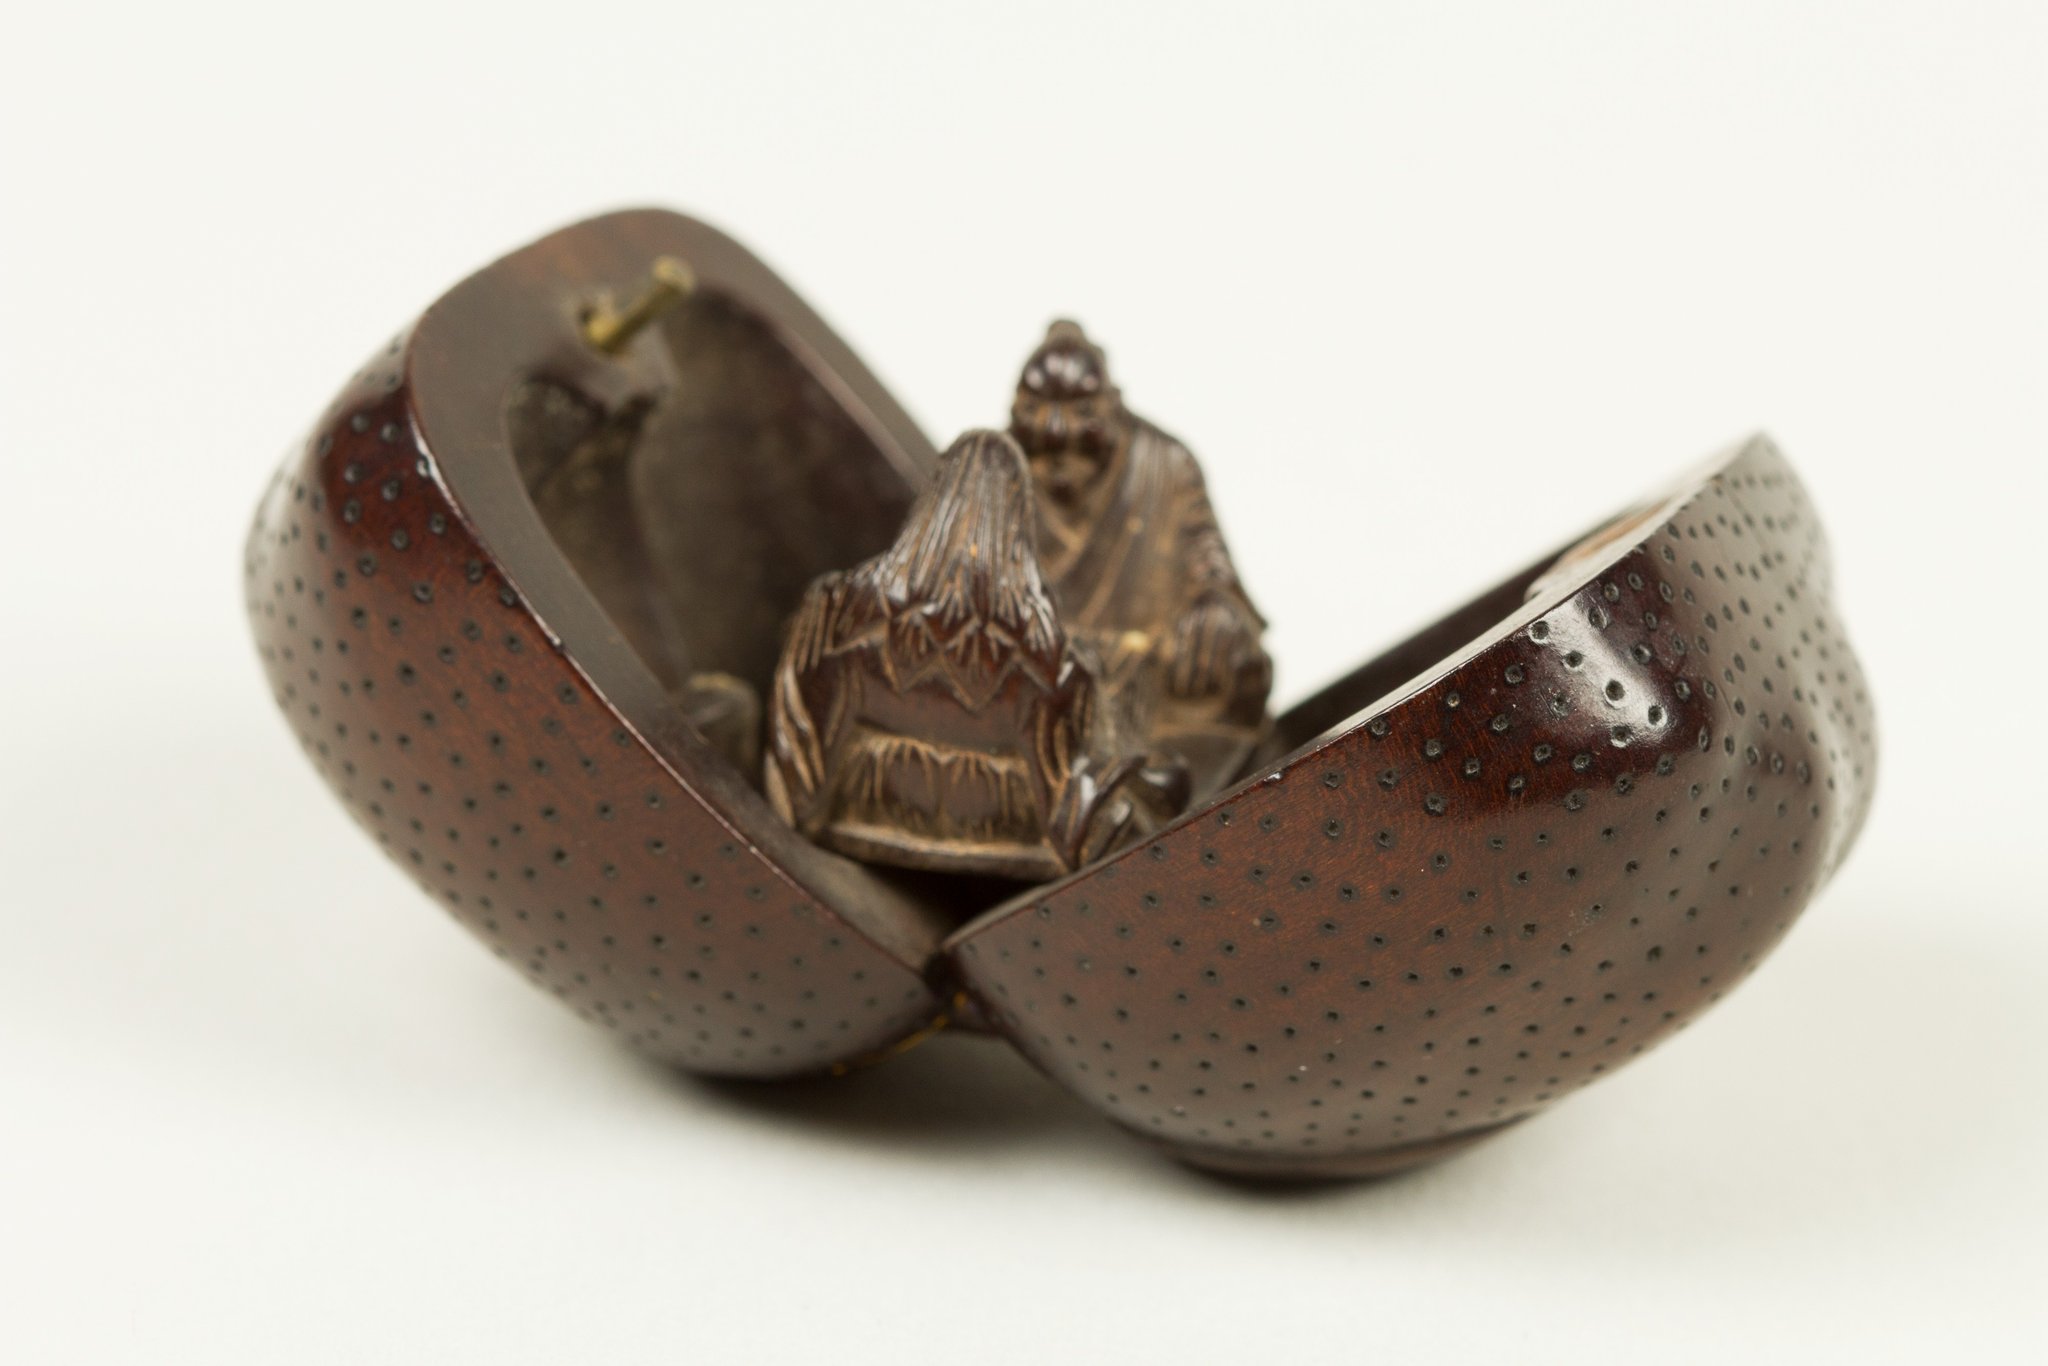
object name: netsuke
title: Netsuke in Shape of a Biwa Fruit containing Court Figures Playing Game of Go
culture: japanese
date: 1801-1833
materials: wood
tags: human figures,games